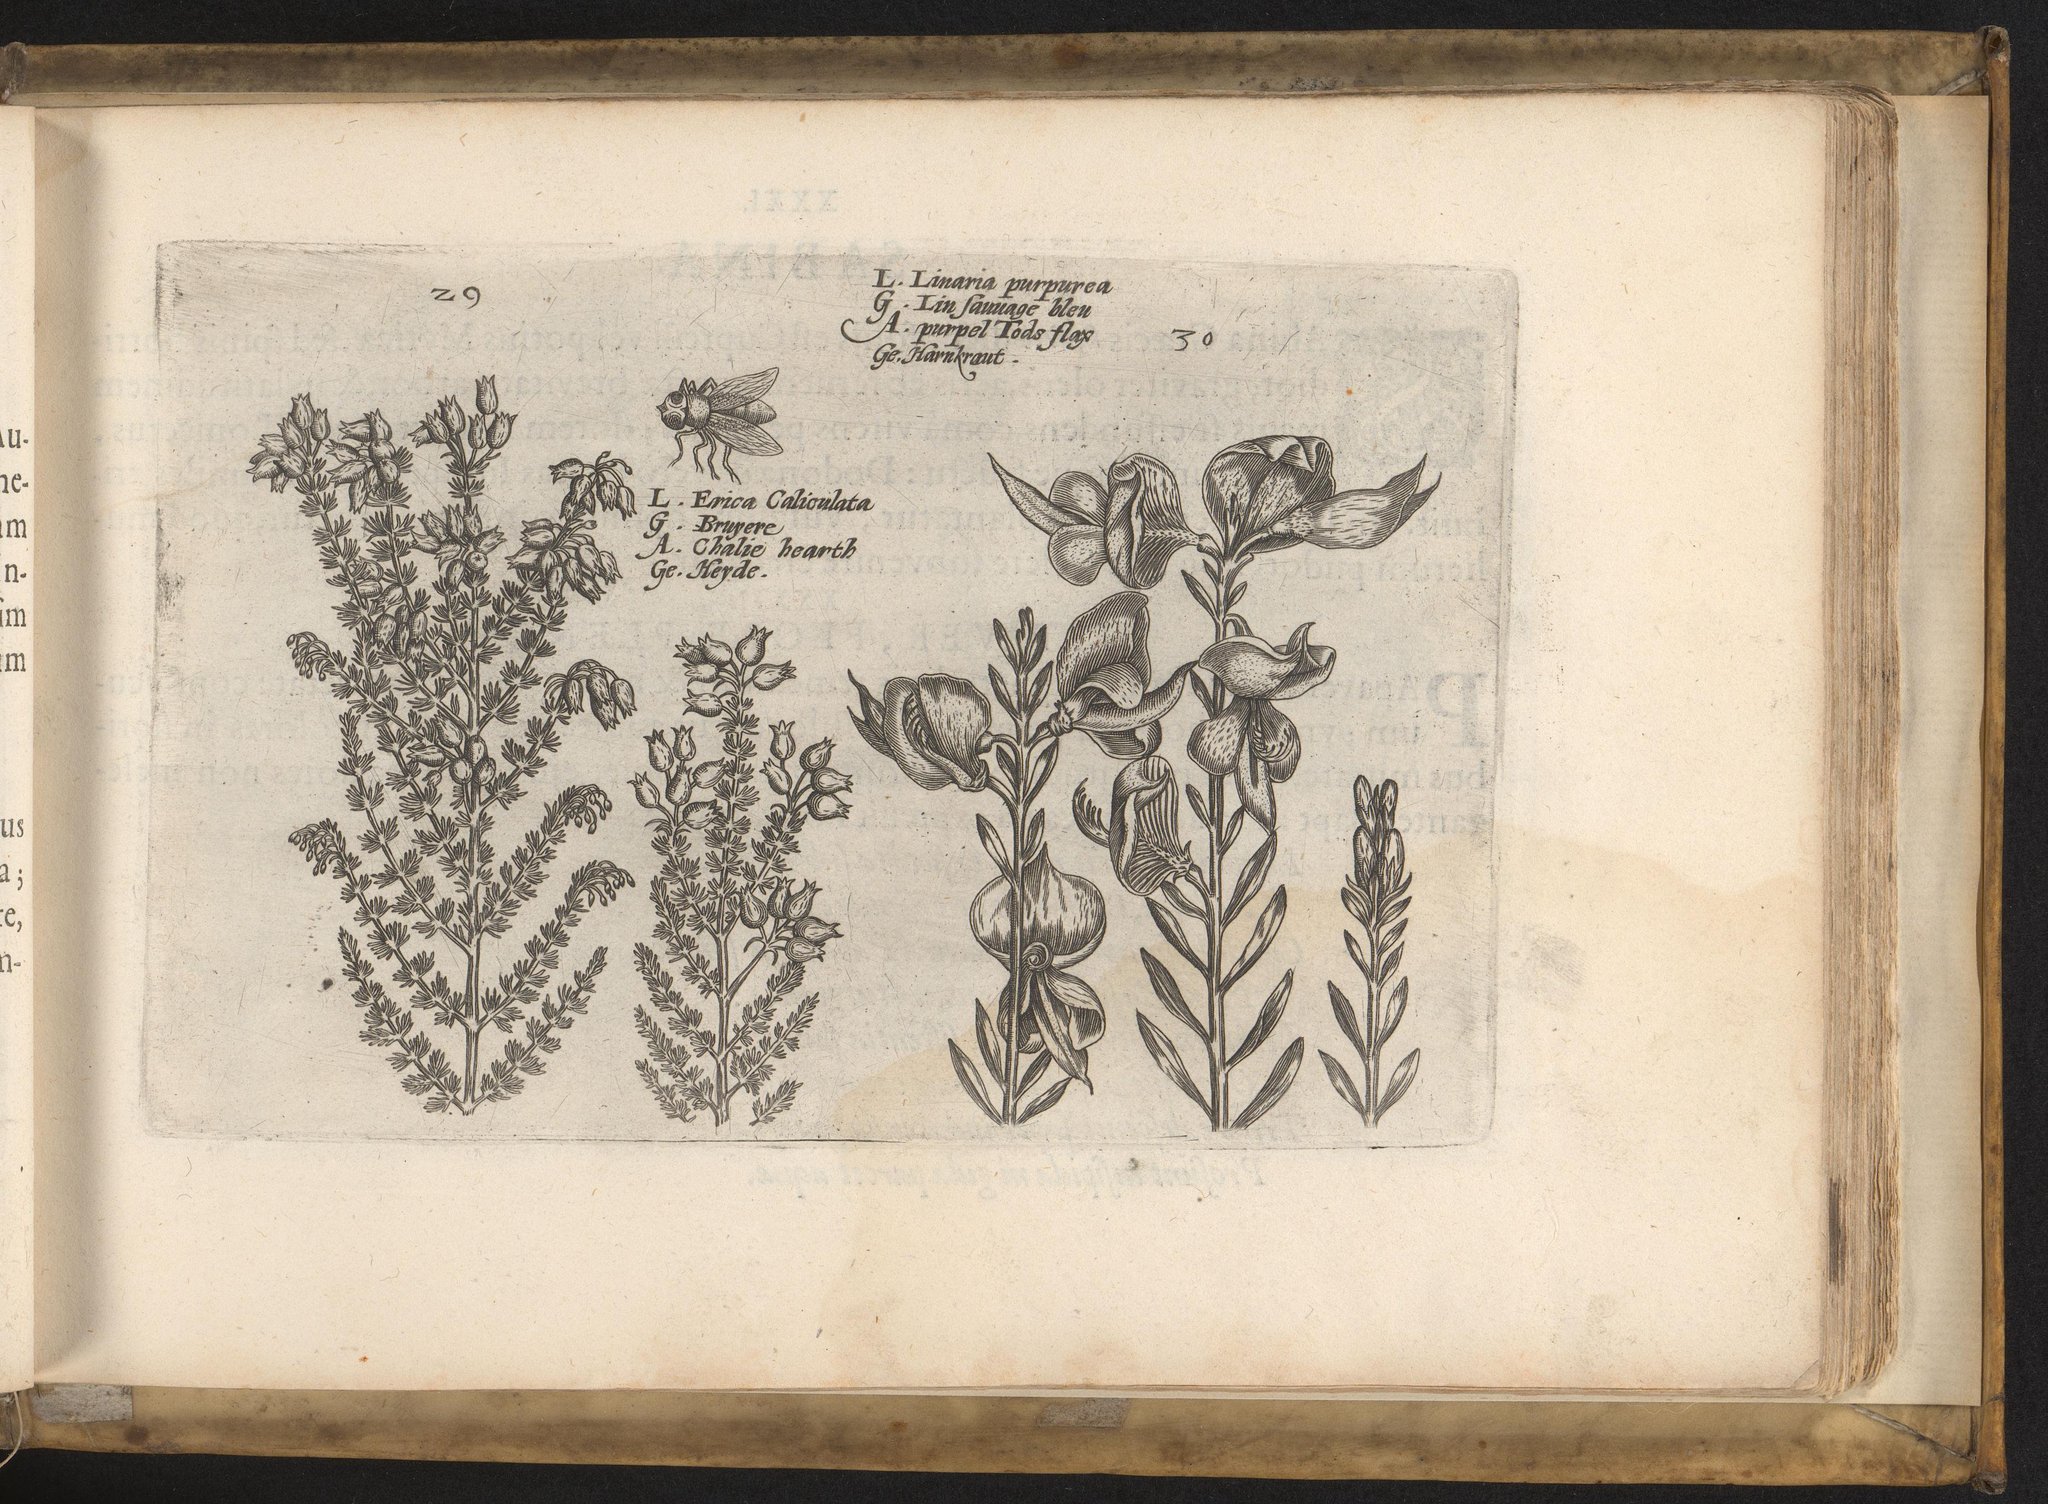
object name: page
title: Hortus floridus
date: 1617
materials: paper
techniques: engraving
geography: arnhem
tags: flowers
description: Prent uit: Passe, Crispijn van de (II). Hortus floridus in quo rariorum & minus vulgarium florum icones ad vivam veramque formam. Arnhem: Johannes Janssonius, 1617.